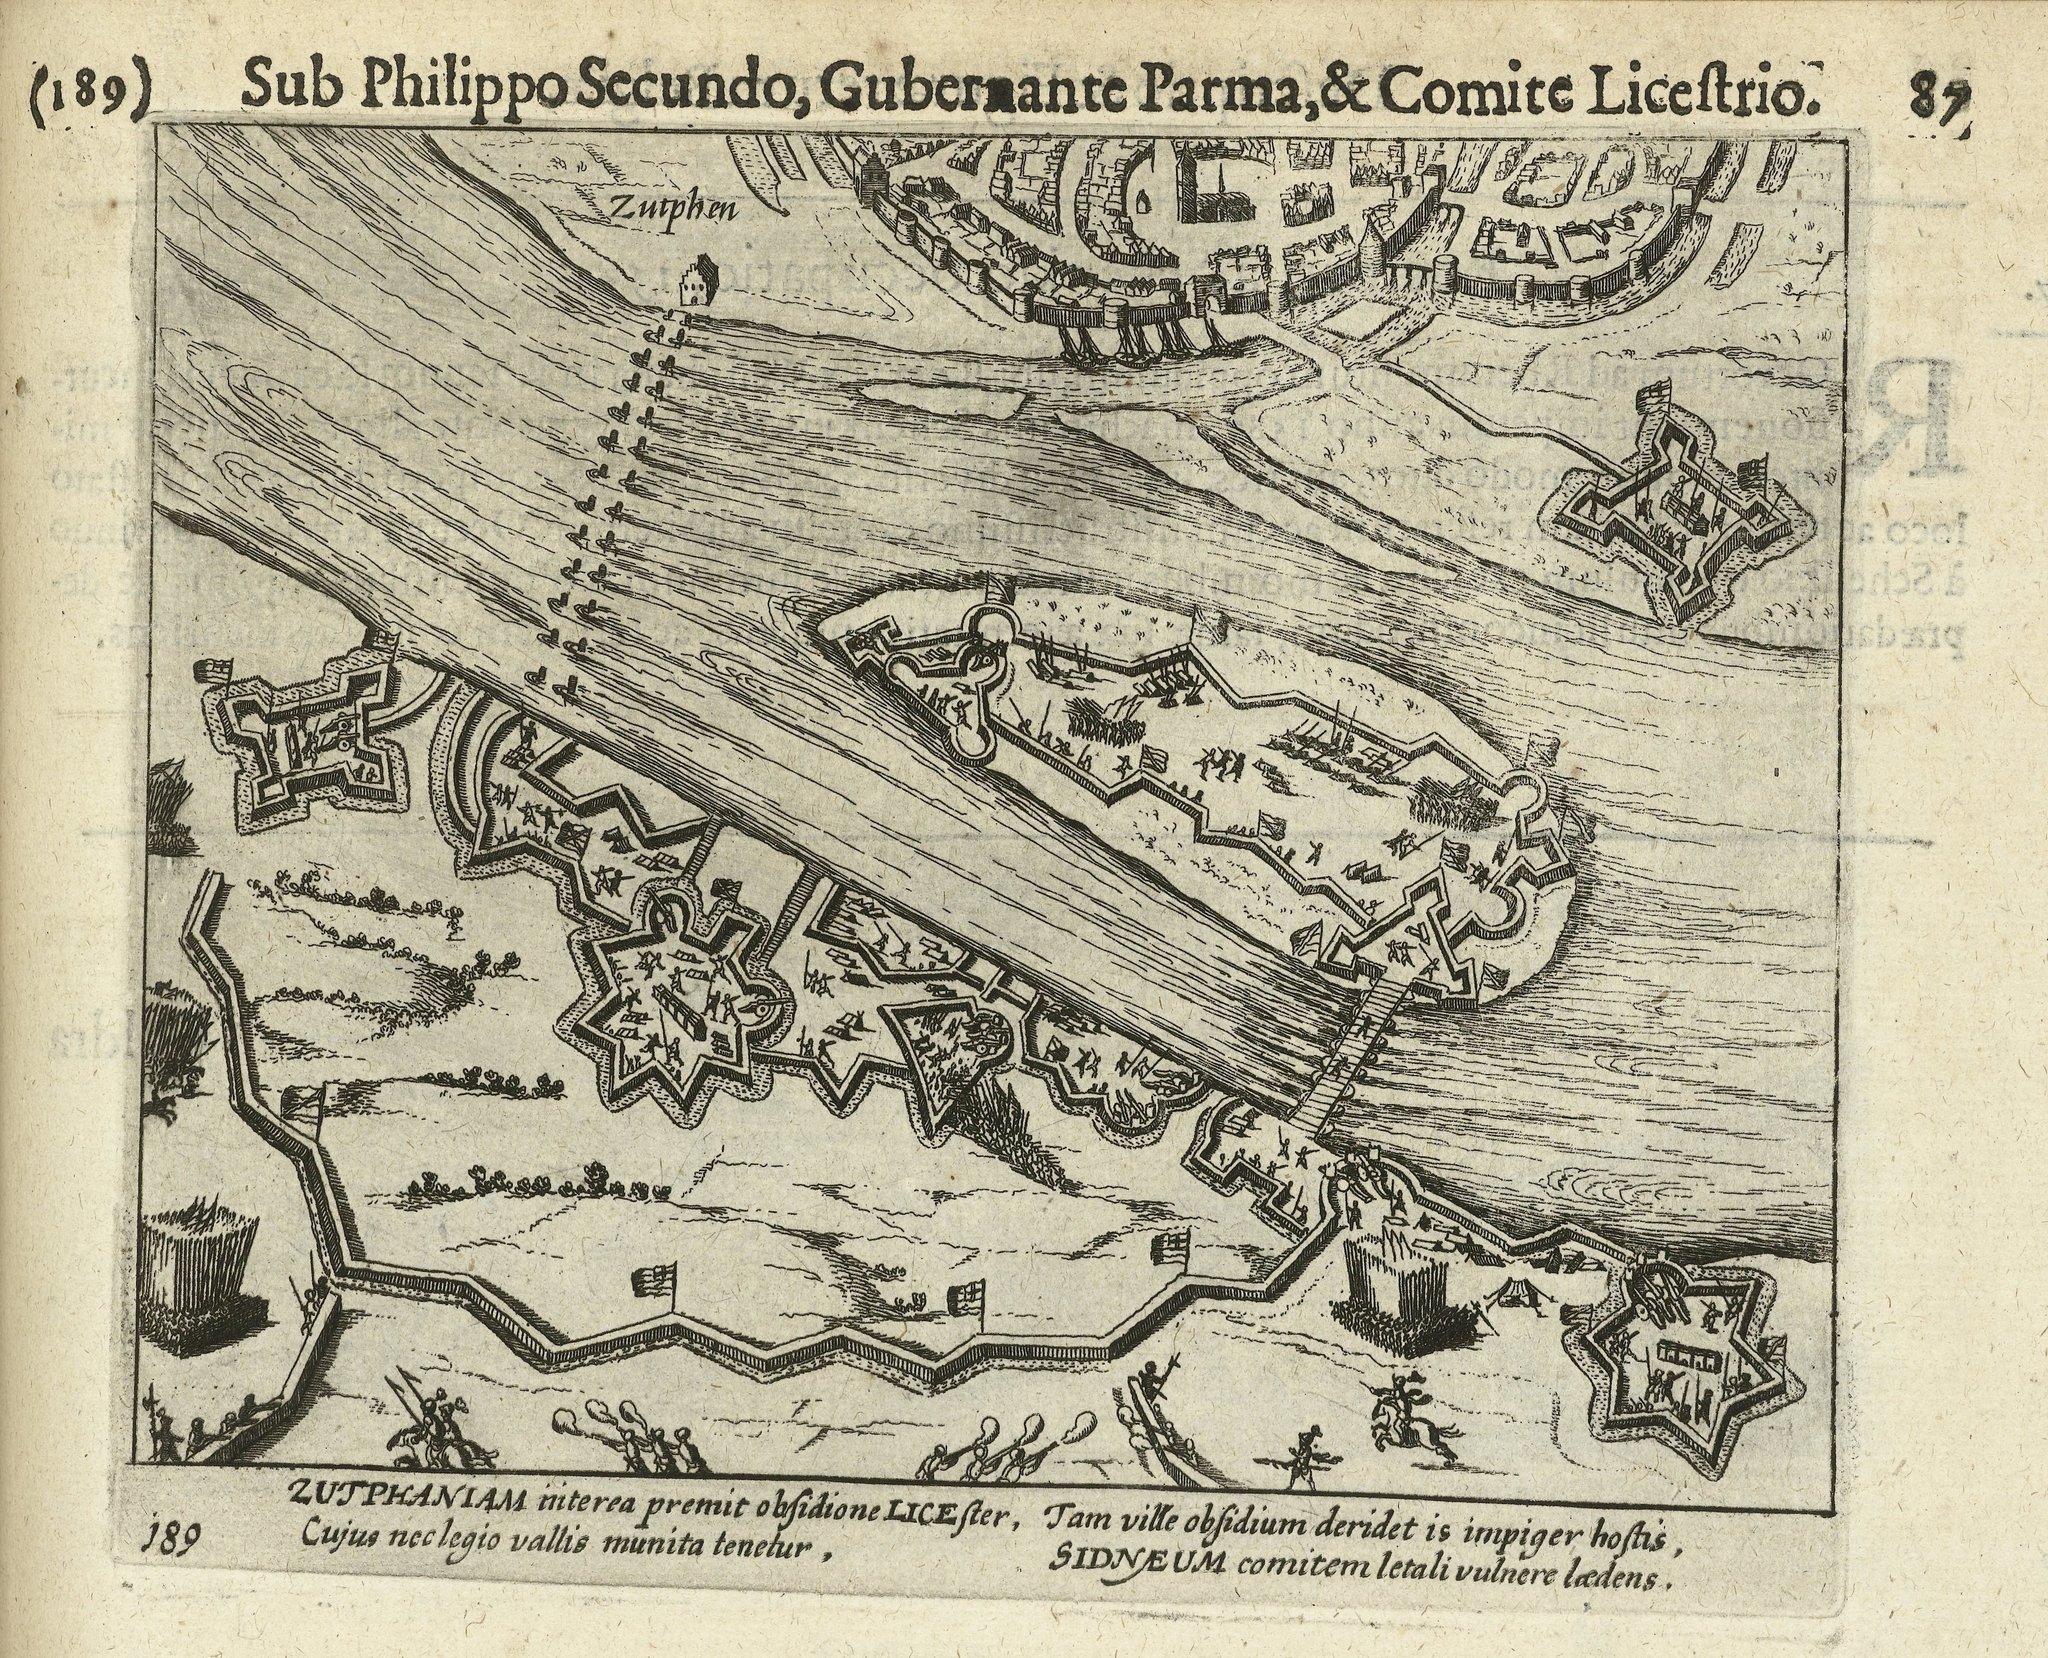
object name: history print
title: Beleg van Zutphen door Leicester, 1586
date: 1613-1615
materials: paper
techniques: etching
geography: northern netherlands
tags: siege, position war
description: Beleg van Zutphen door de troepen van de graaf van Leicester, september en oktober 1586. Gezicht op Zutphen en de Engelse en Spaanse schansen langs de IJssel. Met onderschrift van 4 regels in het Latijn. Genummerd 189. Bedrukt op achterzijde met tekst in het Latijn.